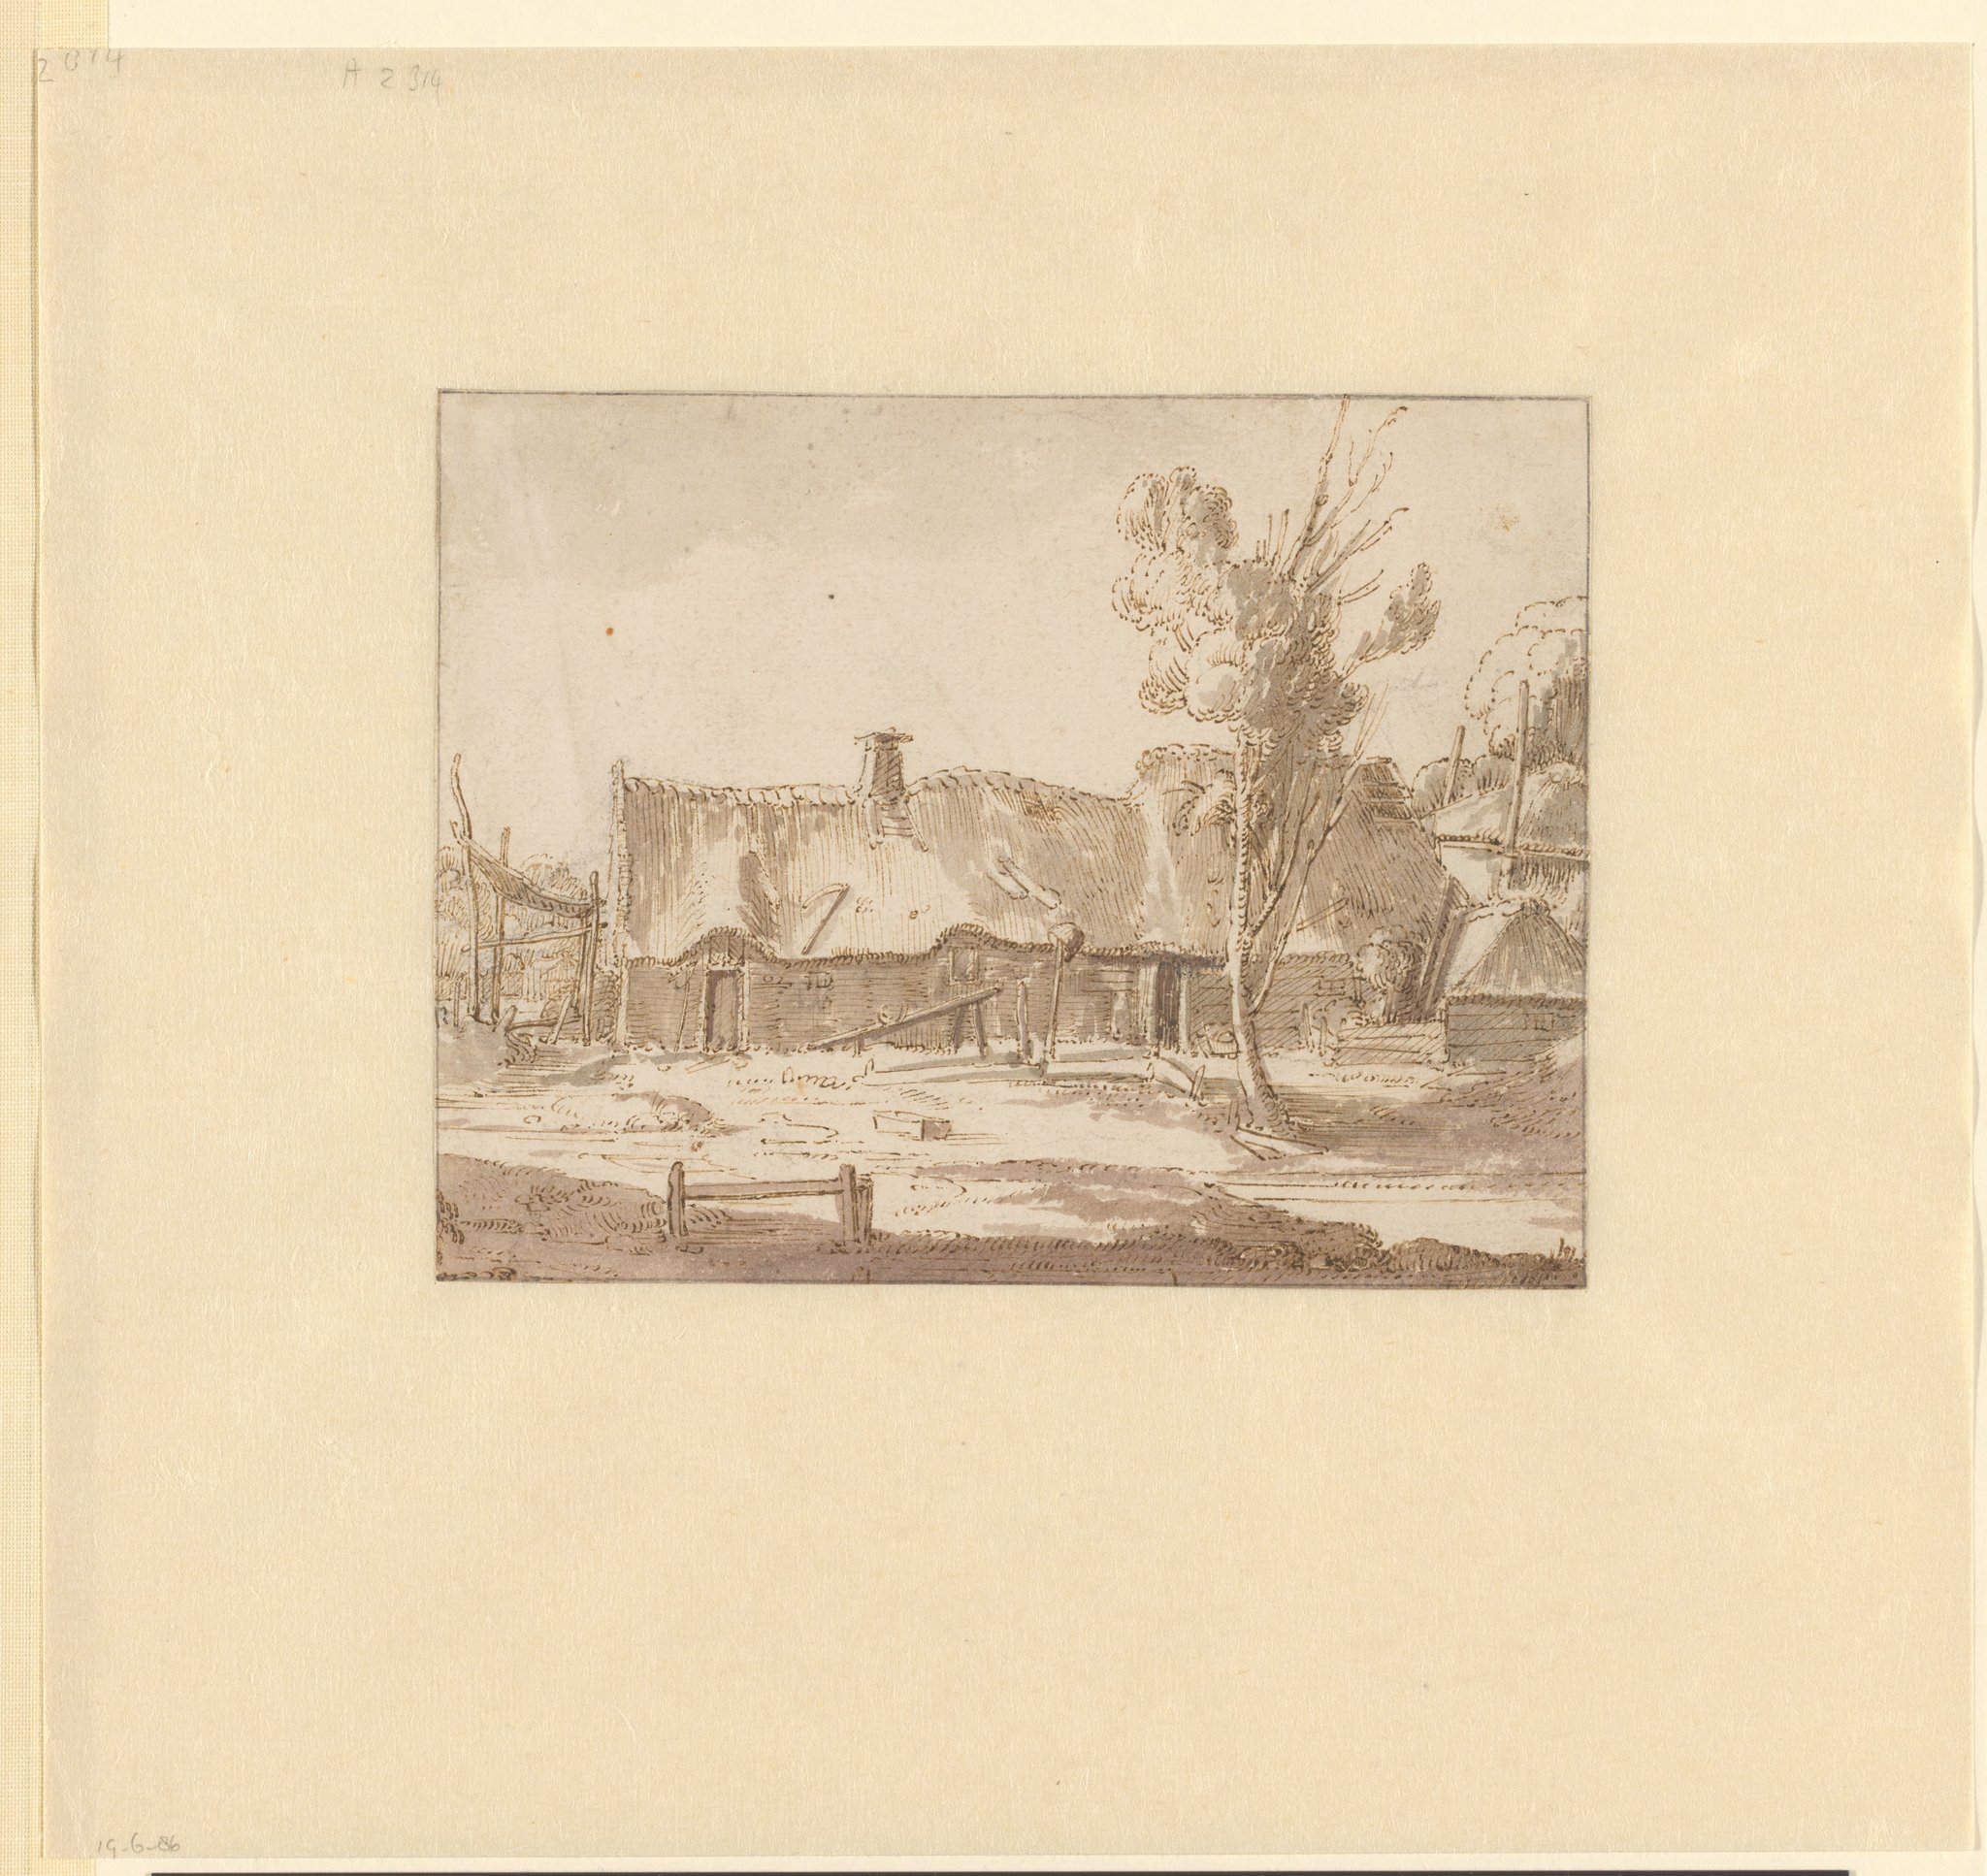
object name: drawing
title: Boerderij met hooiberg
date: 1640-1676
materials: ink, paper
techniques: brush, pen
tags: farm (building)